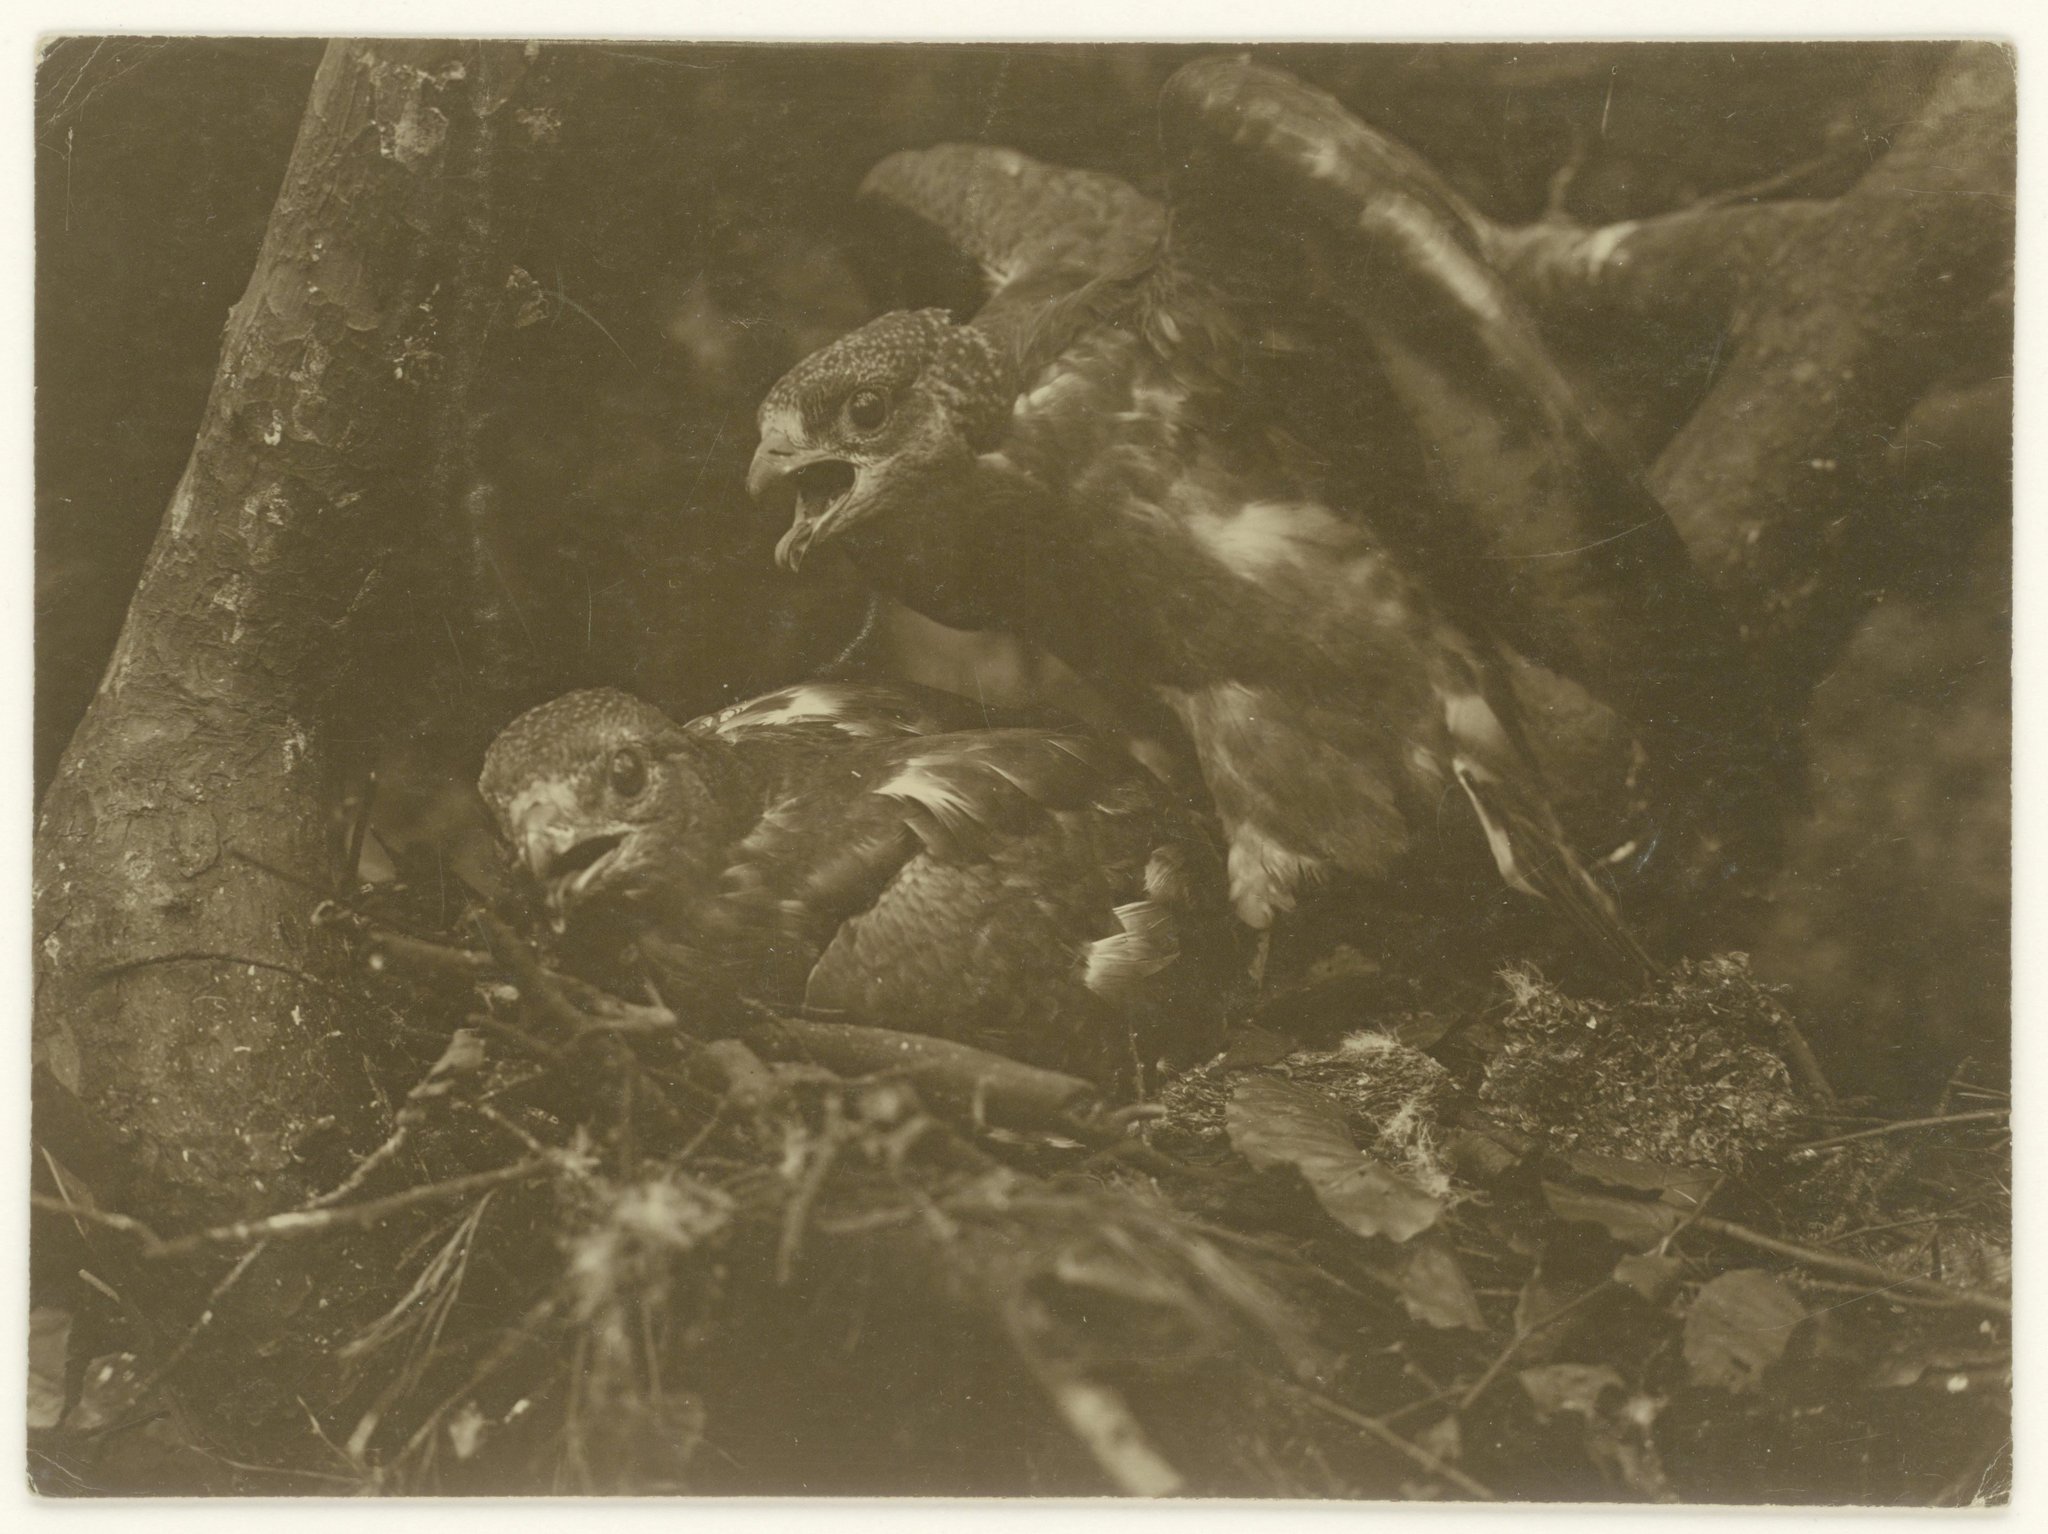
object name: photograph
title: Twee jonge wespendieven in park het Loo in Apeldoorn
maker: richard tepe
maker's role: fotograaf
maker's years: 1864-1952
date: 1900-1930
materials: paper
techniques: gelatin silver print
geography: apeldoorn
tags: birds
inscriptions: inscription: ‘Halbwüchsige Jungen des Wespenbussards im Horst in einer hohen Kiefer rechts ein paar ausgefressene Stücke Wespenwebe im Königlichem Park Het Loo in het Loo bei Apeldoorn Holland’, signature: ‘foto R Tepe’